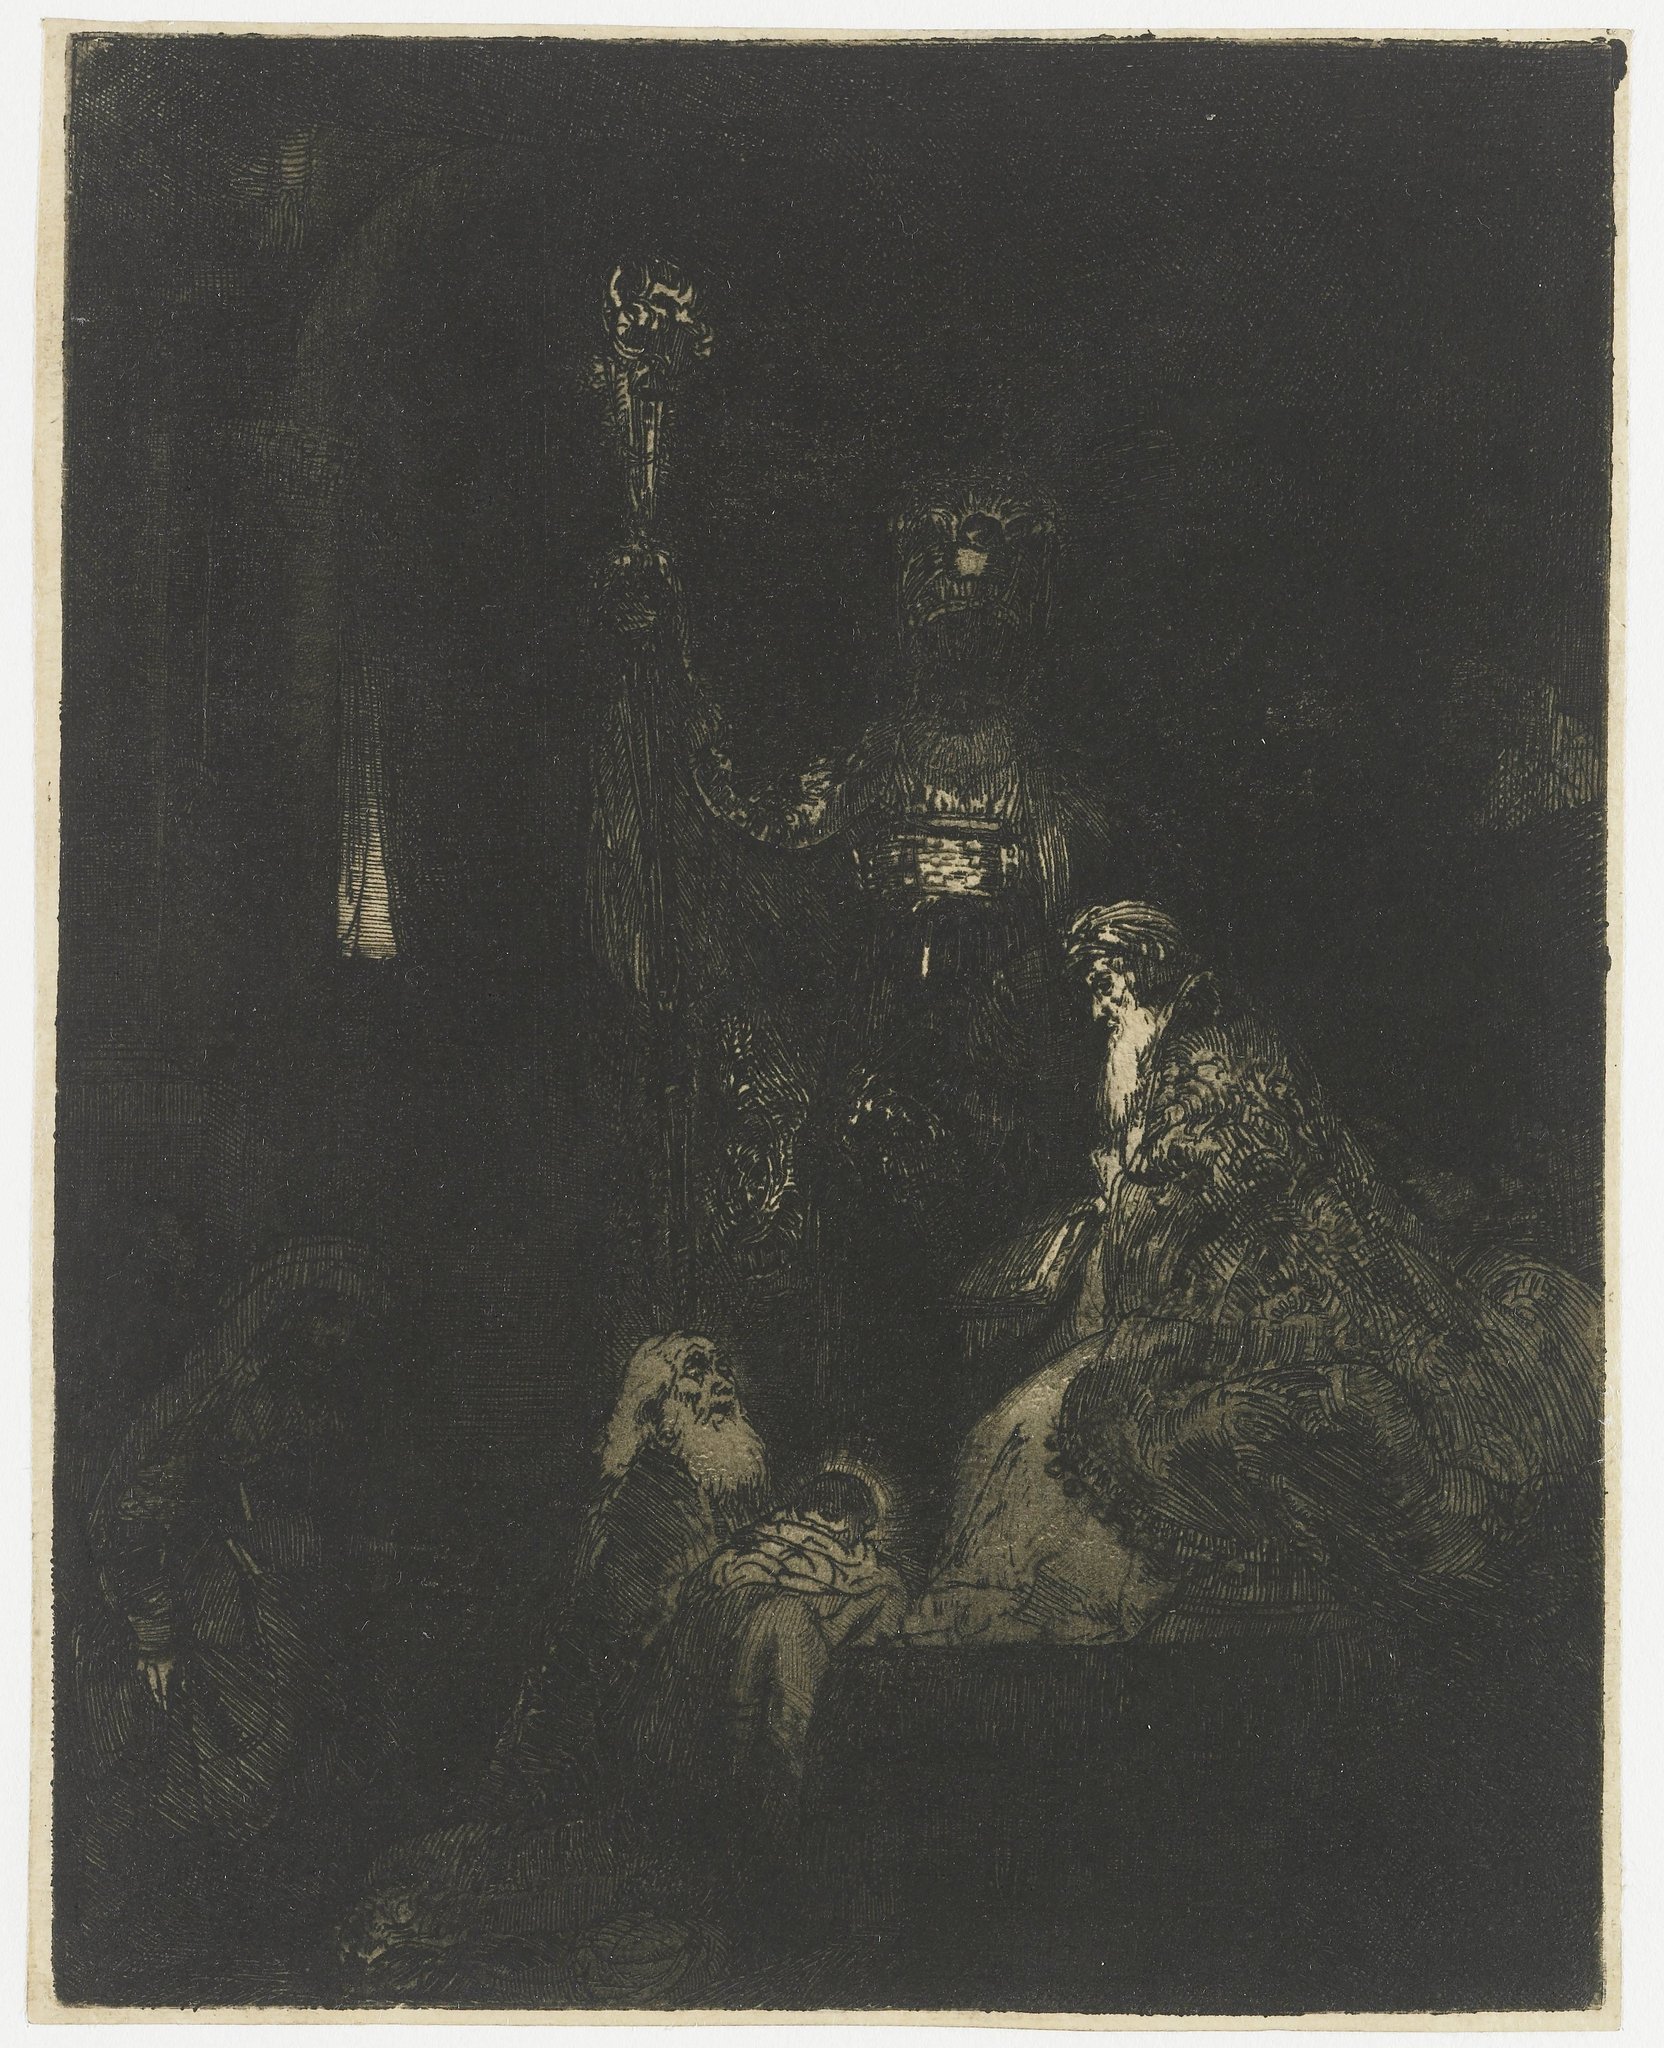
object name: print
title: The presentation in the temple in the dark manner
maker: rembrandt van rijn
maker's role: draughtsman, painter, print maker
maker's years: 1606-1669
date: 1654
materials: paper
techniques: drypoint, etching, intaglio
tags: simeon, holding the christ-child, sings his canticle: 'nunc dimittis'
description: Around 1654 Rembrandt depicted four events in the life of Christ in the same format, paying special attention to the light. In this first print in the series the aged Simeon is shown holding the newborn Jesus in the Temple. He realizes that the infant is the long-awaited Saviour. Rembrandt left a thin layer of ink on the print (surface tone) causing the scene to loom out of a mysterious semi-darkness.